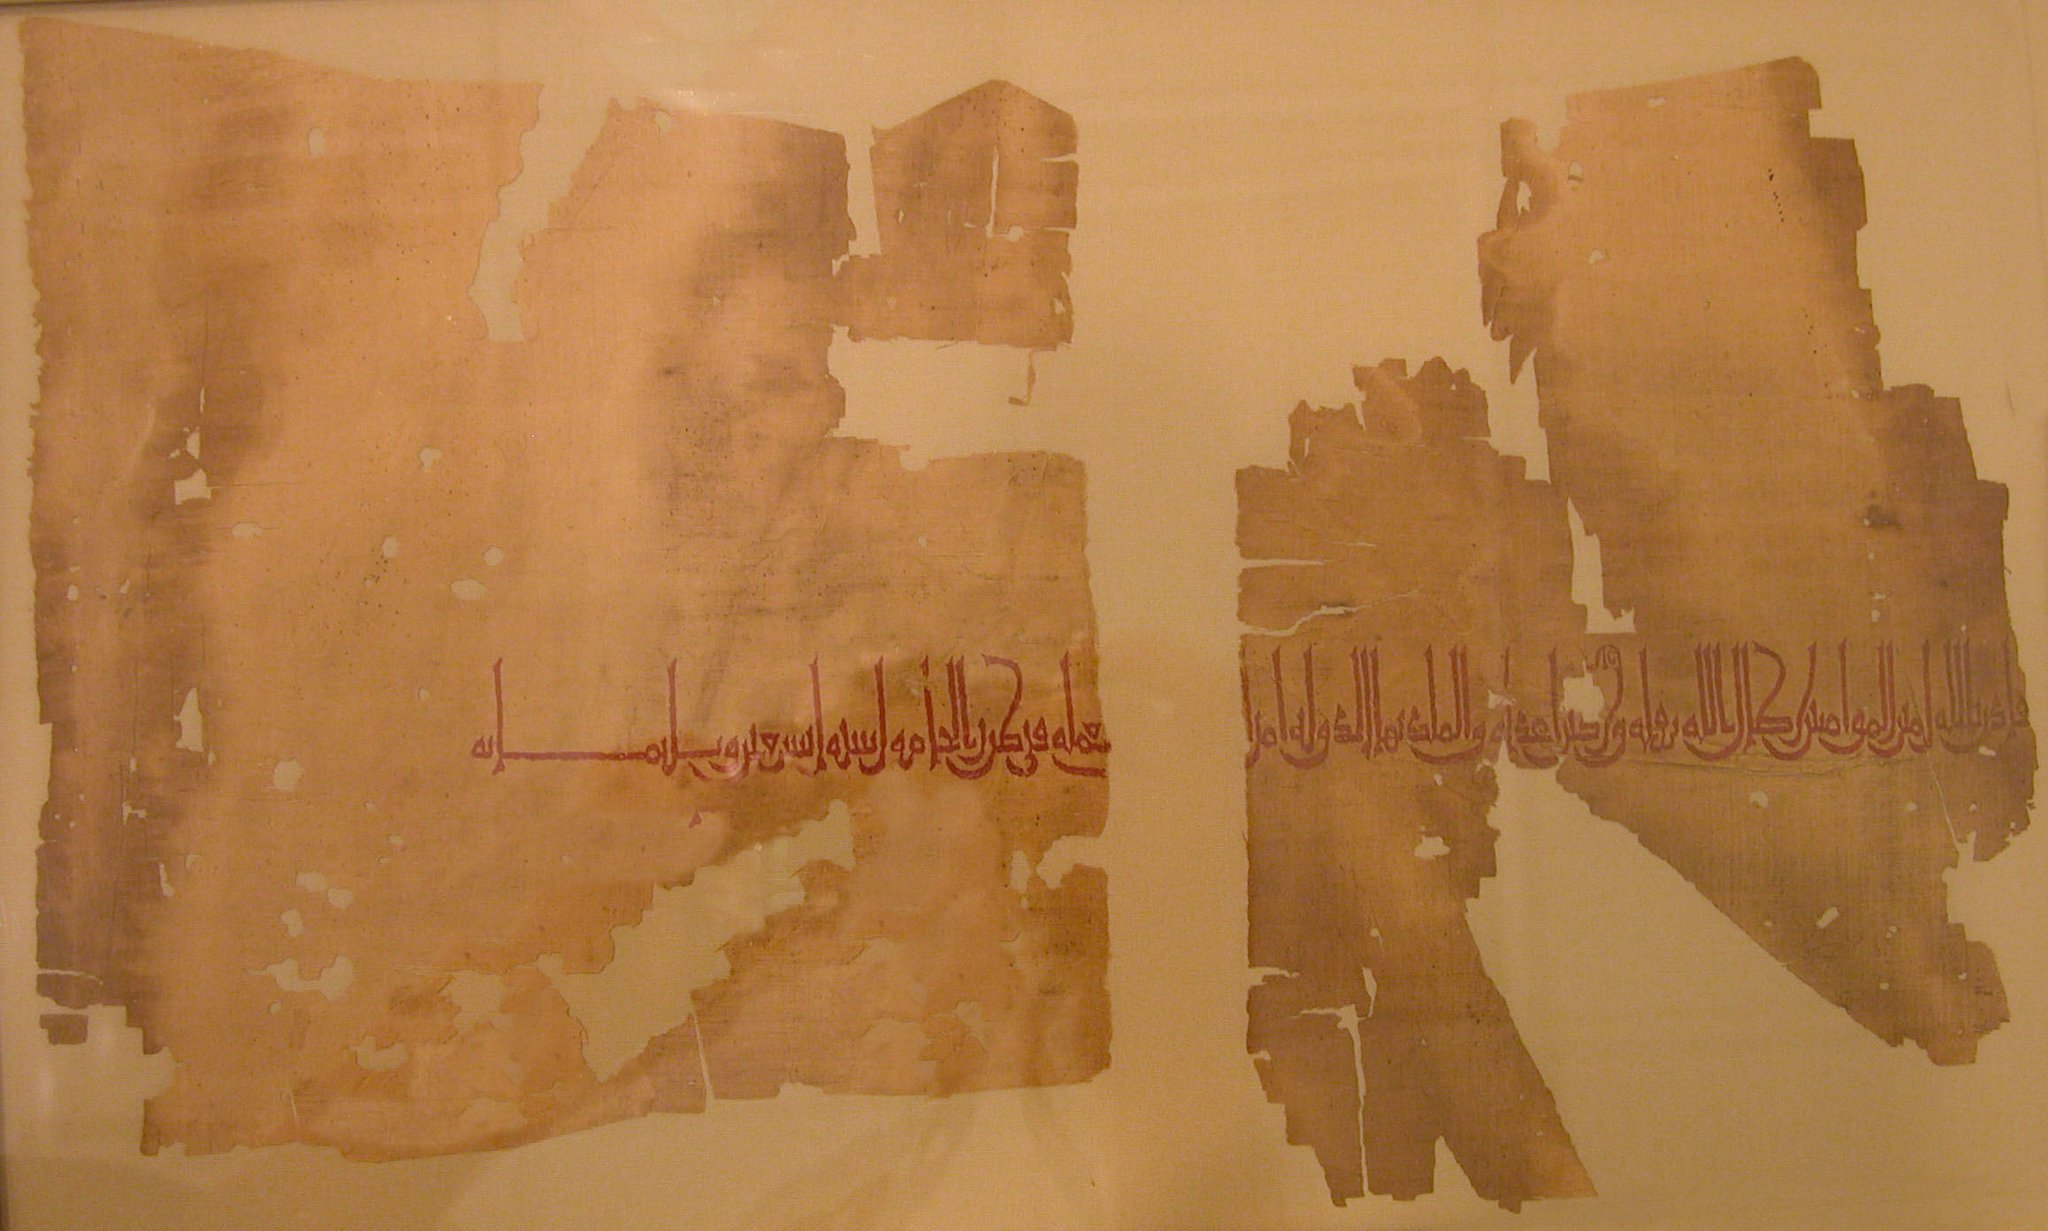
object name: textile fragment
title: Tiraz Textile Fragment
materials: linen, silk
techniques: embroidery, weave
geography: iraq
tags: arabic